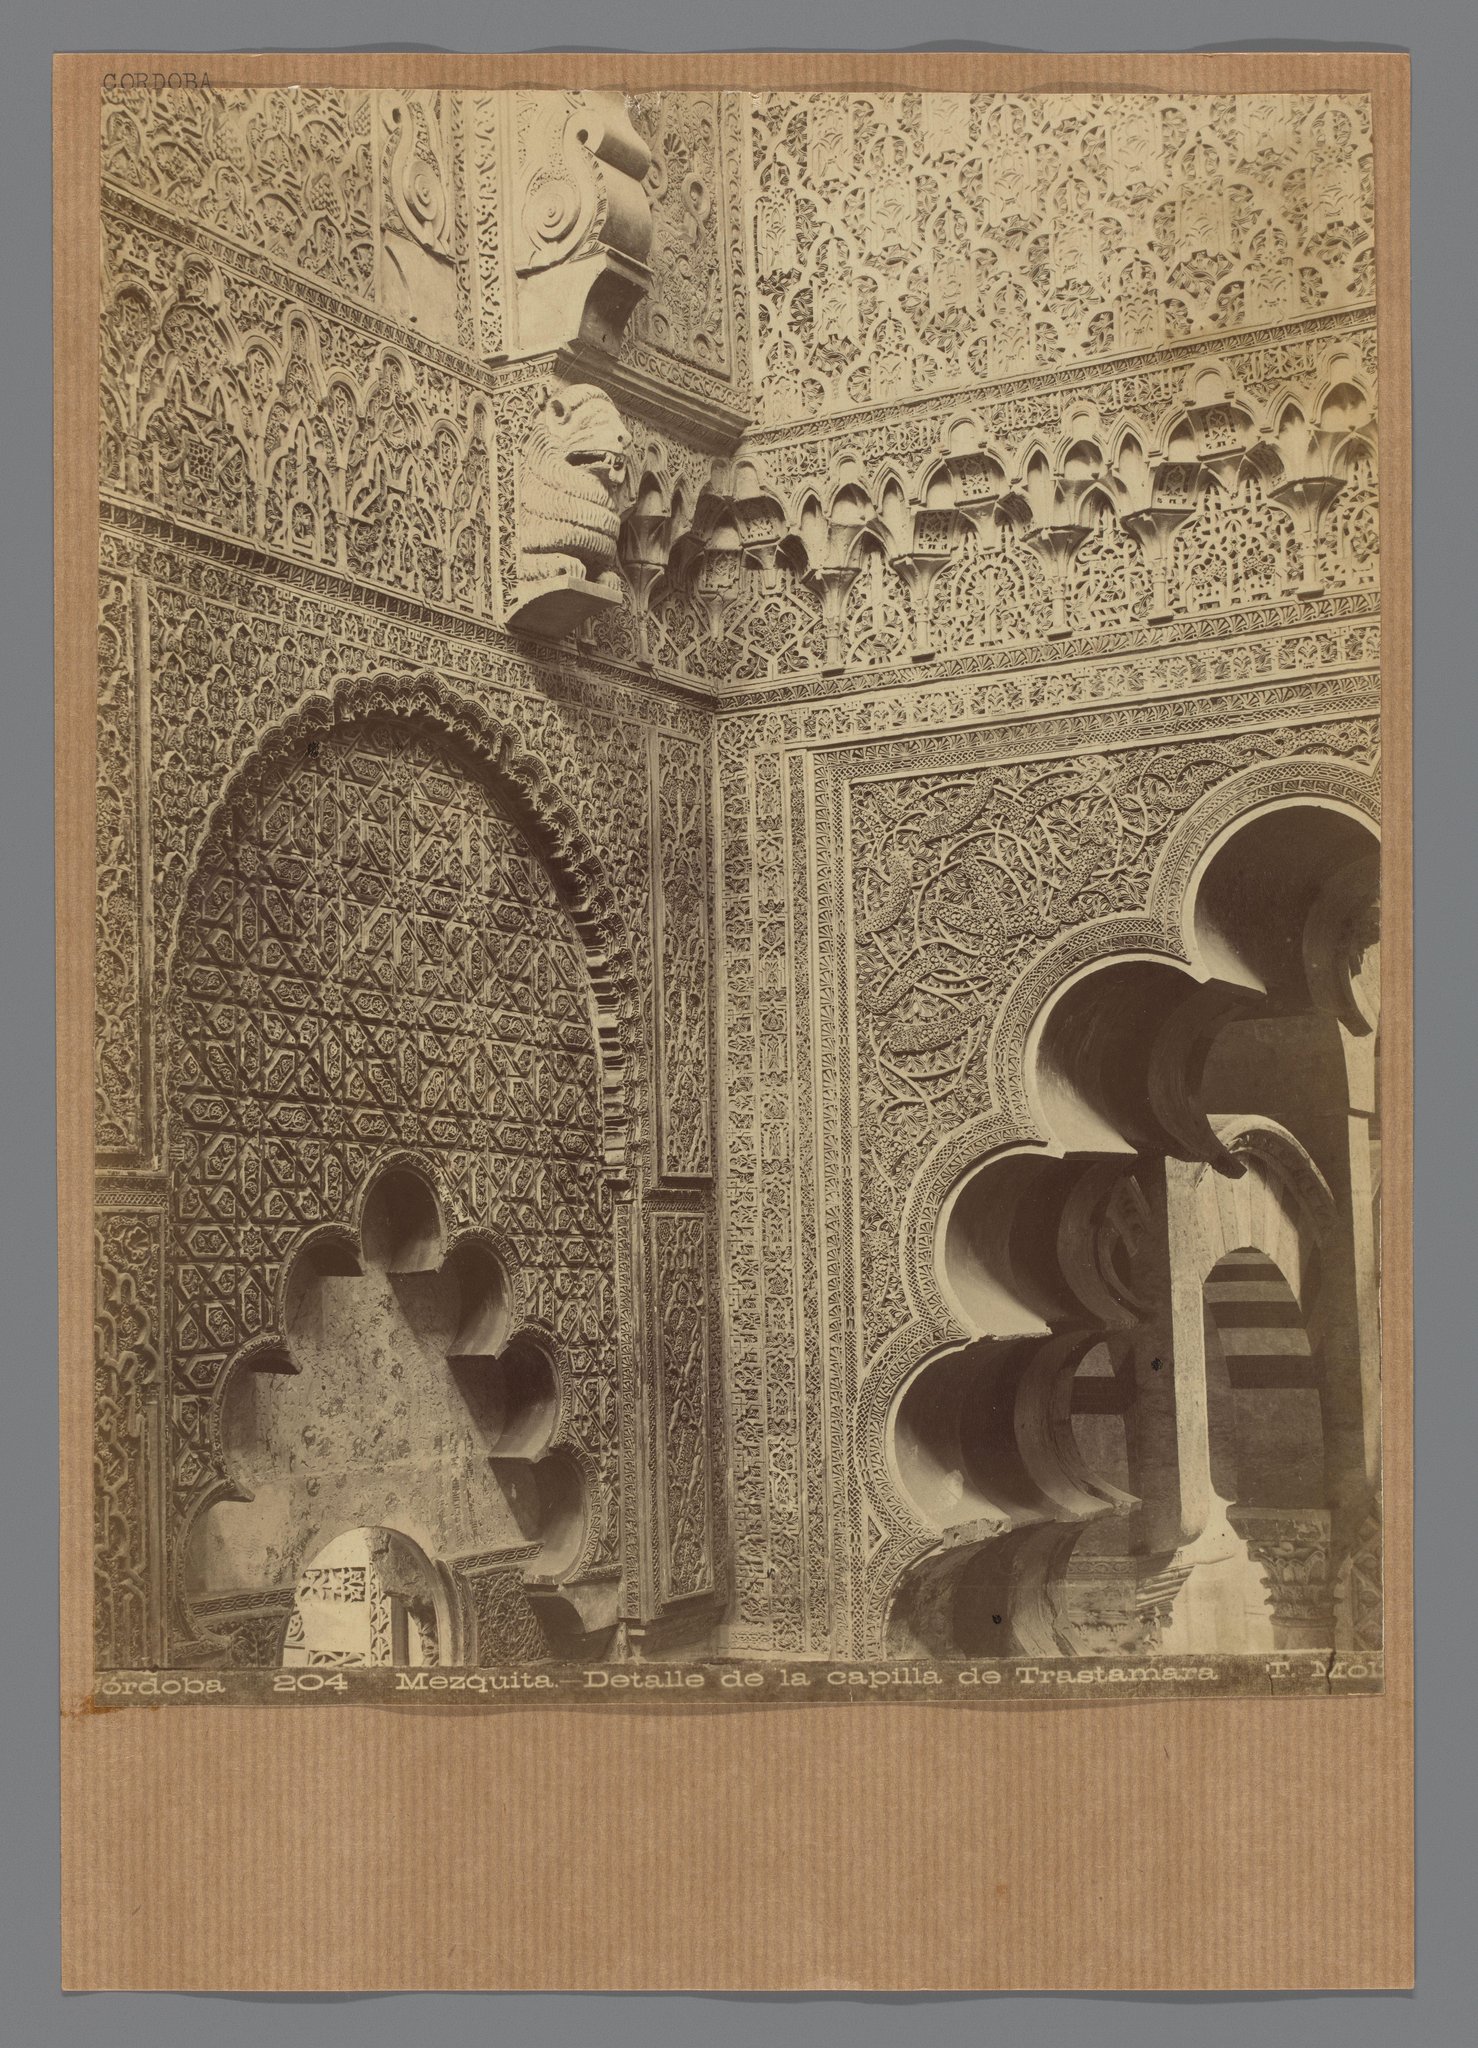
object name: photograph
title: Moskee Cordoba, interieurdetails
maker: Anonymous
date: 1850-1899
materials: paper, photographic support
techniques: albumen print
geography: spain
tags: mezquita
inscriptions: stamp: ‘UNIVERSITEIT VAN AMSTERDAM / KUNST / HISTORISCH / INSTITUUT’, inscription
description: Foto uit de studiecollectie van het Kunsthistorisch Instituut van de Universiteit van Amsterdam.